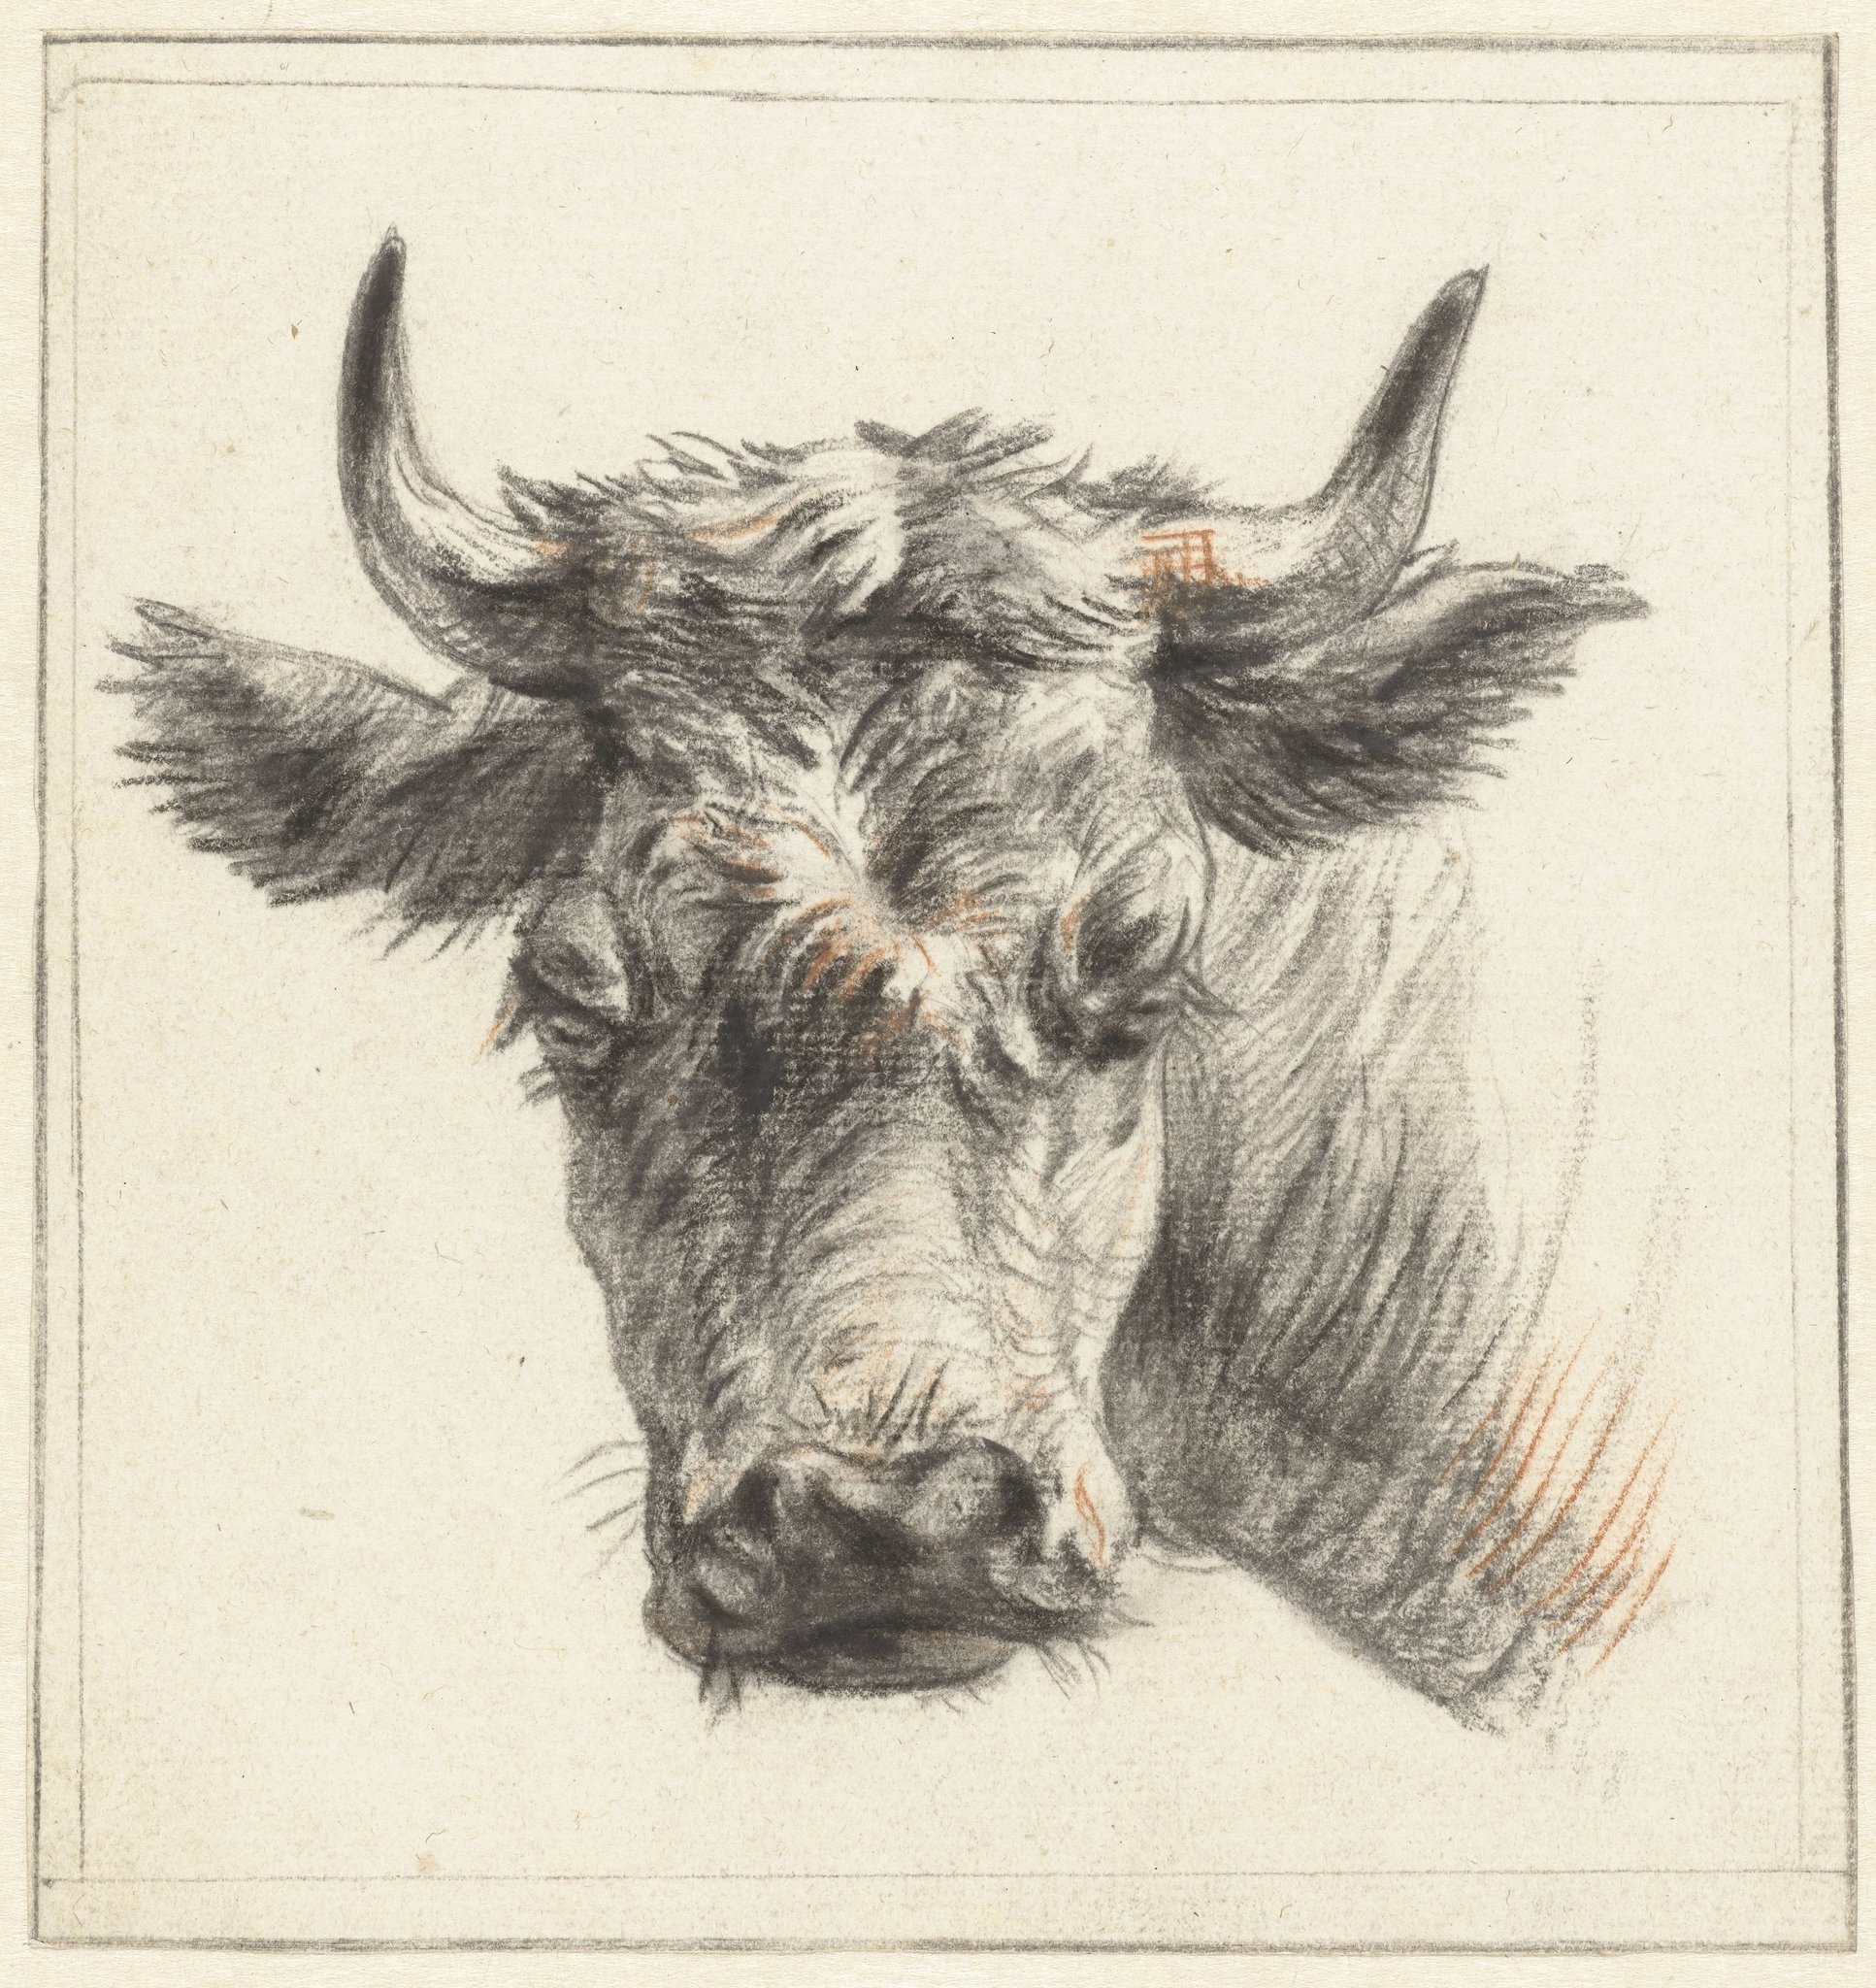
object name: drawing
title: Kop van een rund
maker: pieter gerardus van os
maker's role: draughtsman, painter, print maker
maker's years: 1776-1839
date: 1786-1839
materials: chalk, paper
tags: cow